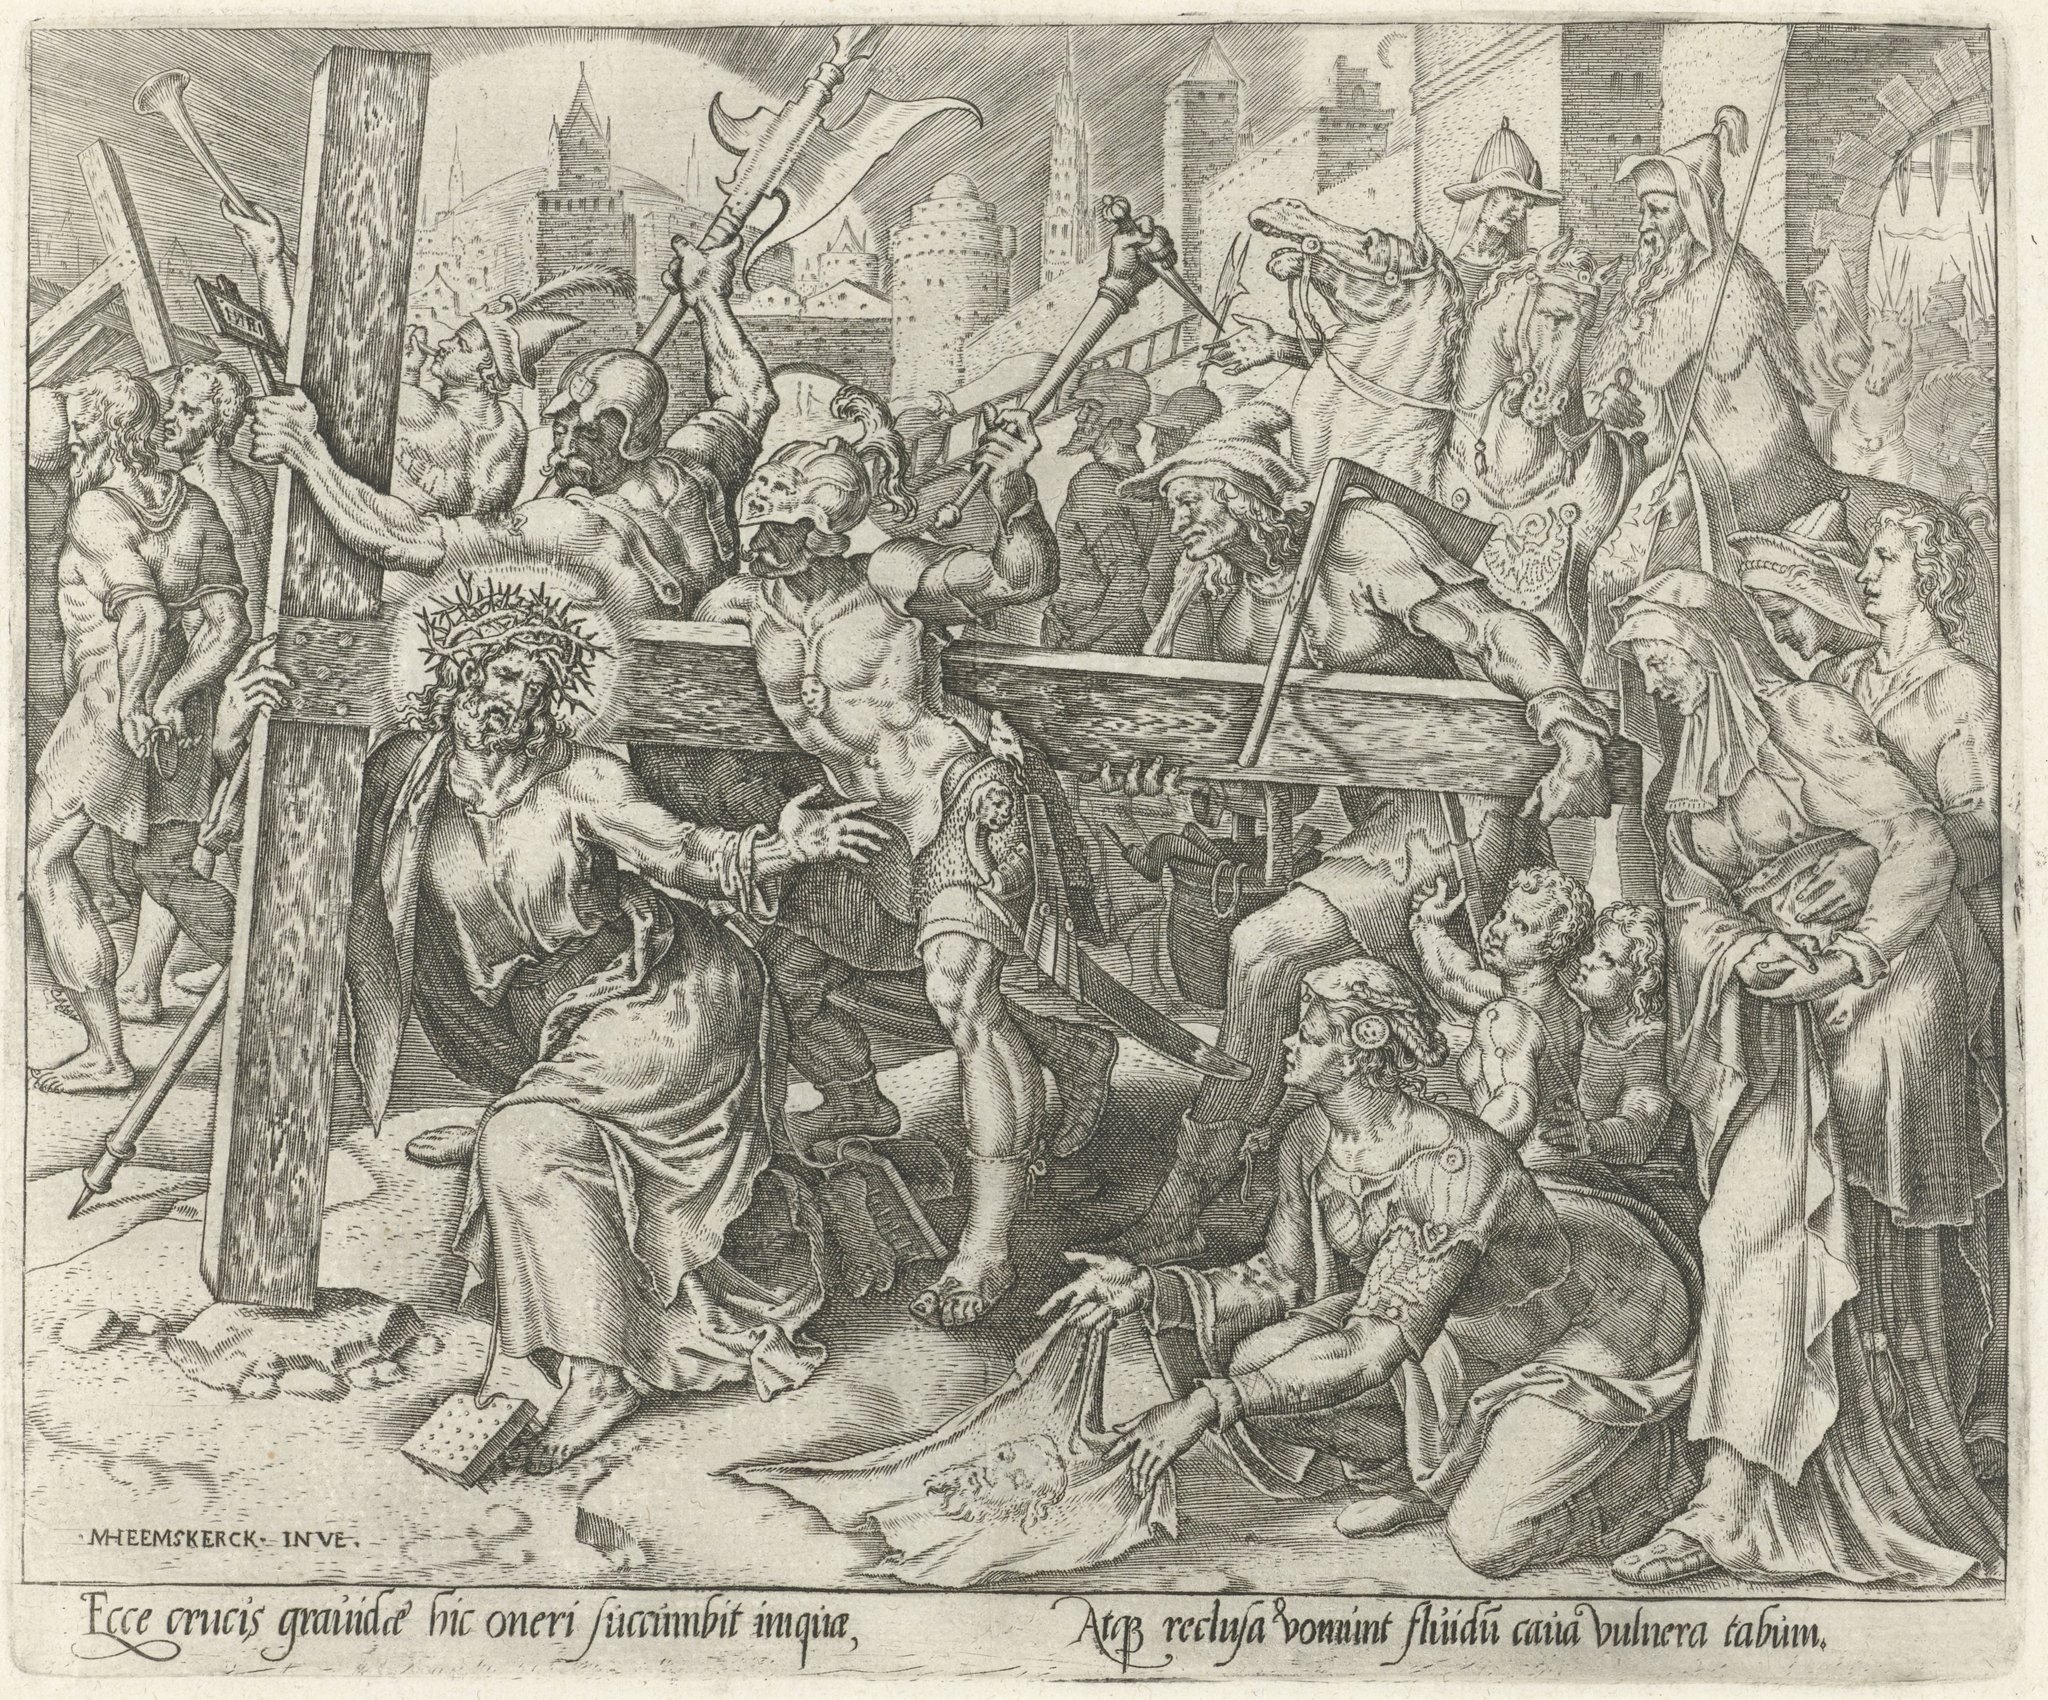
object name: print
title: Zeven bloedingen van Christus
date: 1565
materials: paper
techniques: engraving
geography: amsterdam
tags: christ meets veronica, who has a cloth to wipe christ's face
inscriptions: collector's mark: Lugt 2228, collector's mark: Lugt 2760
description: Christus draagt het kruis en kijkt om naar Veronica, die hem de doek toont, waarop de afdruk van Christus' gelaat achterbleef. Onderaan in de marge een vers in het Latijn. Prent maakt deel uit van een serie over de zeven bloedingen van Christus.